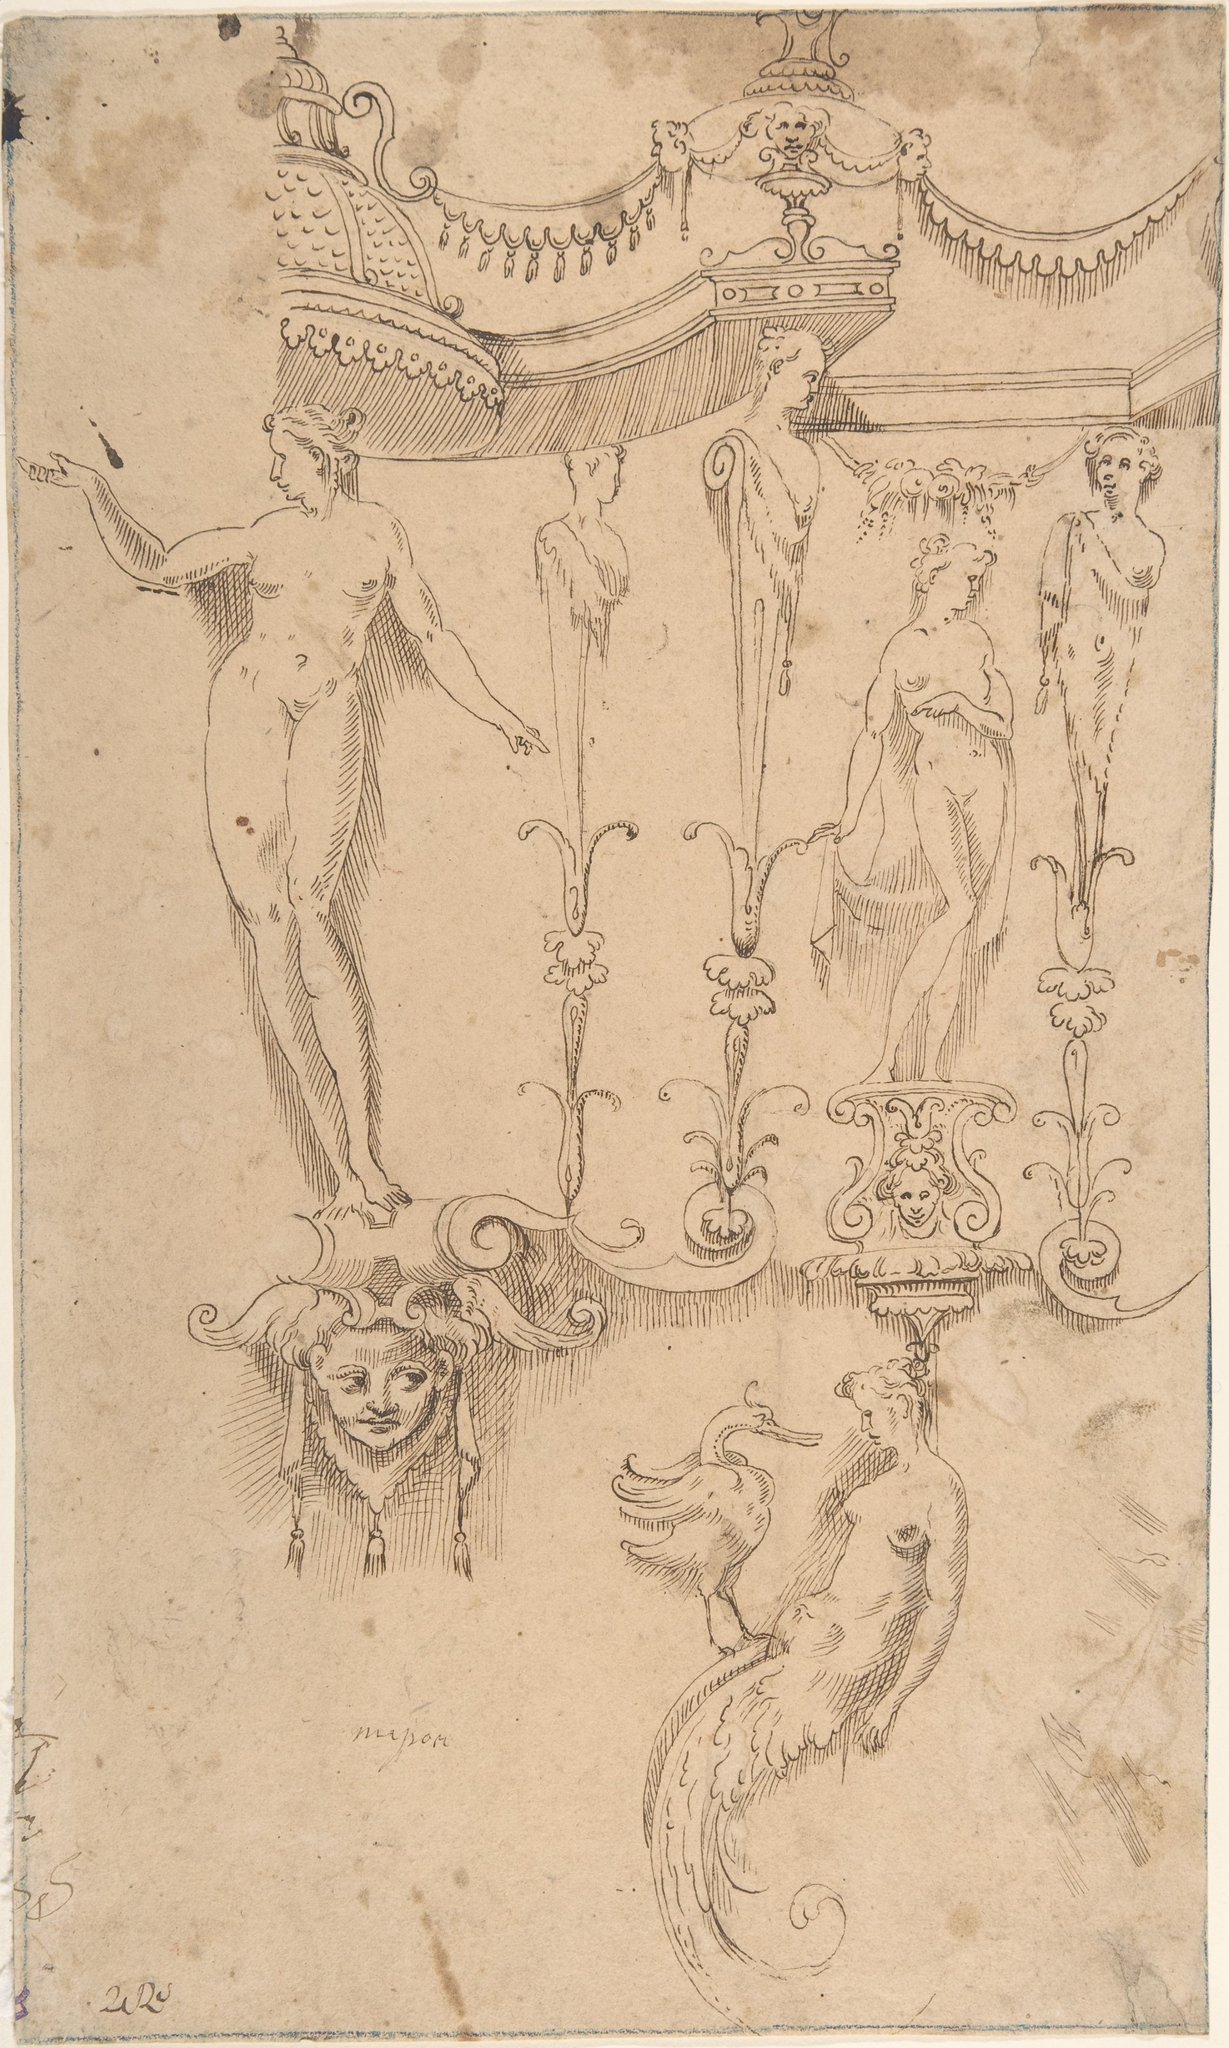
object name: drawing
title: Studies for Grotesque Decorations (recto); Small Sketches and Writing (verso)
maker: anonymous, italian, 17th century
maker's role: artist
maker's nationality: italian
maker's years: 1600-1700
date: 1601-1700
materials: ink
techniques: pen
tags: birds,grotesques,ornament,female nudes